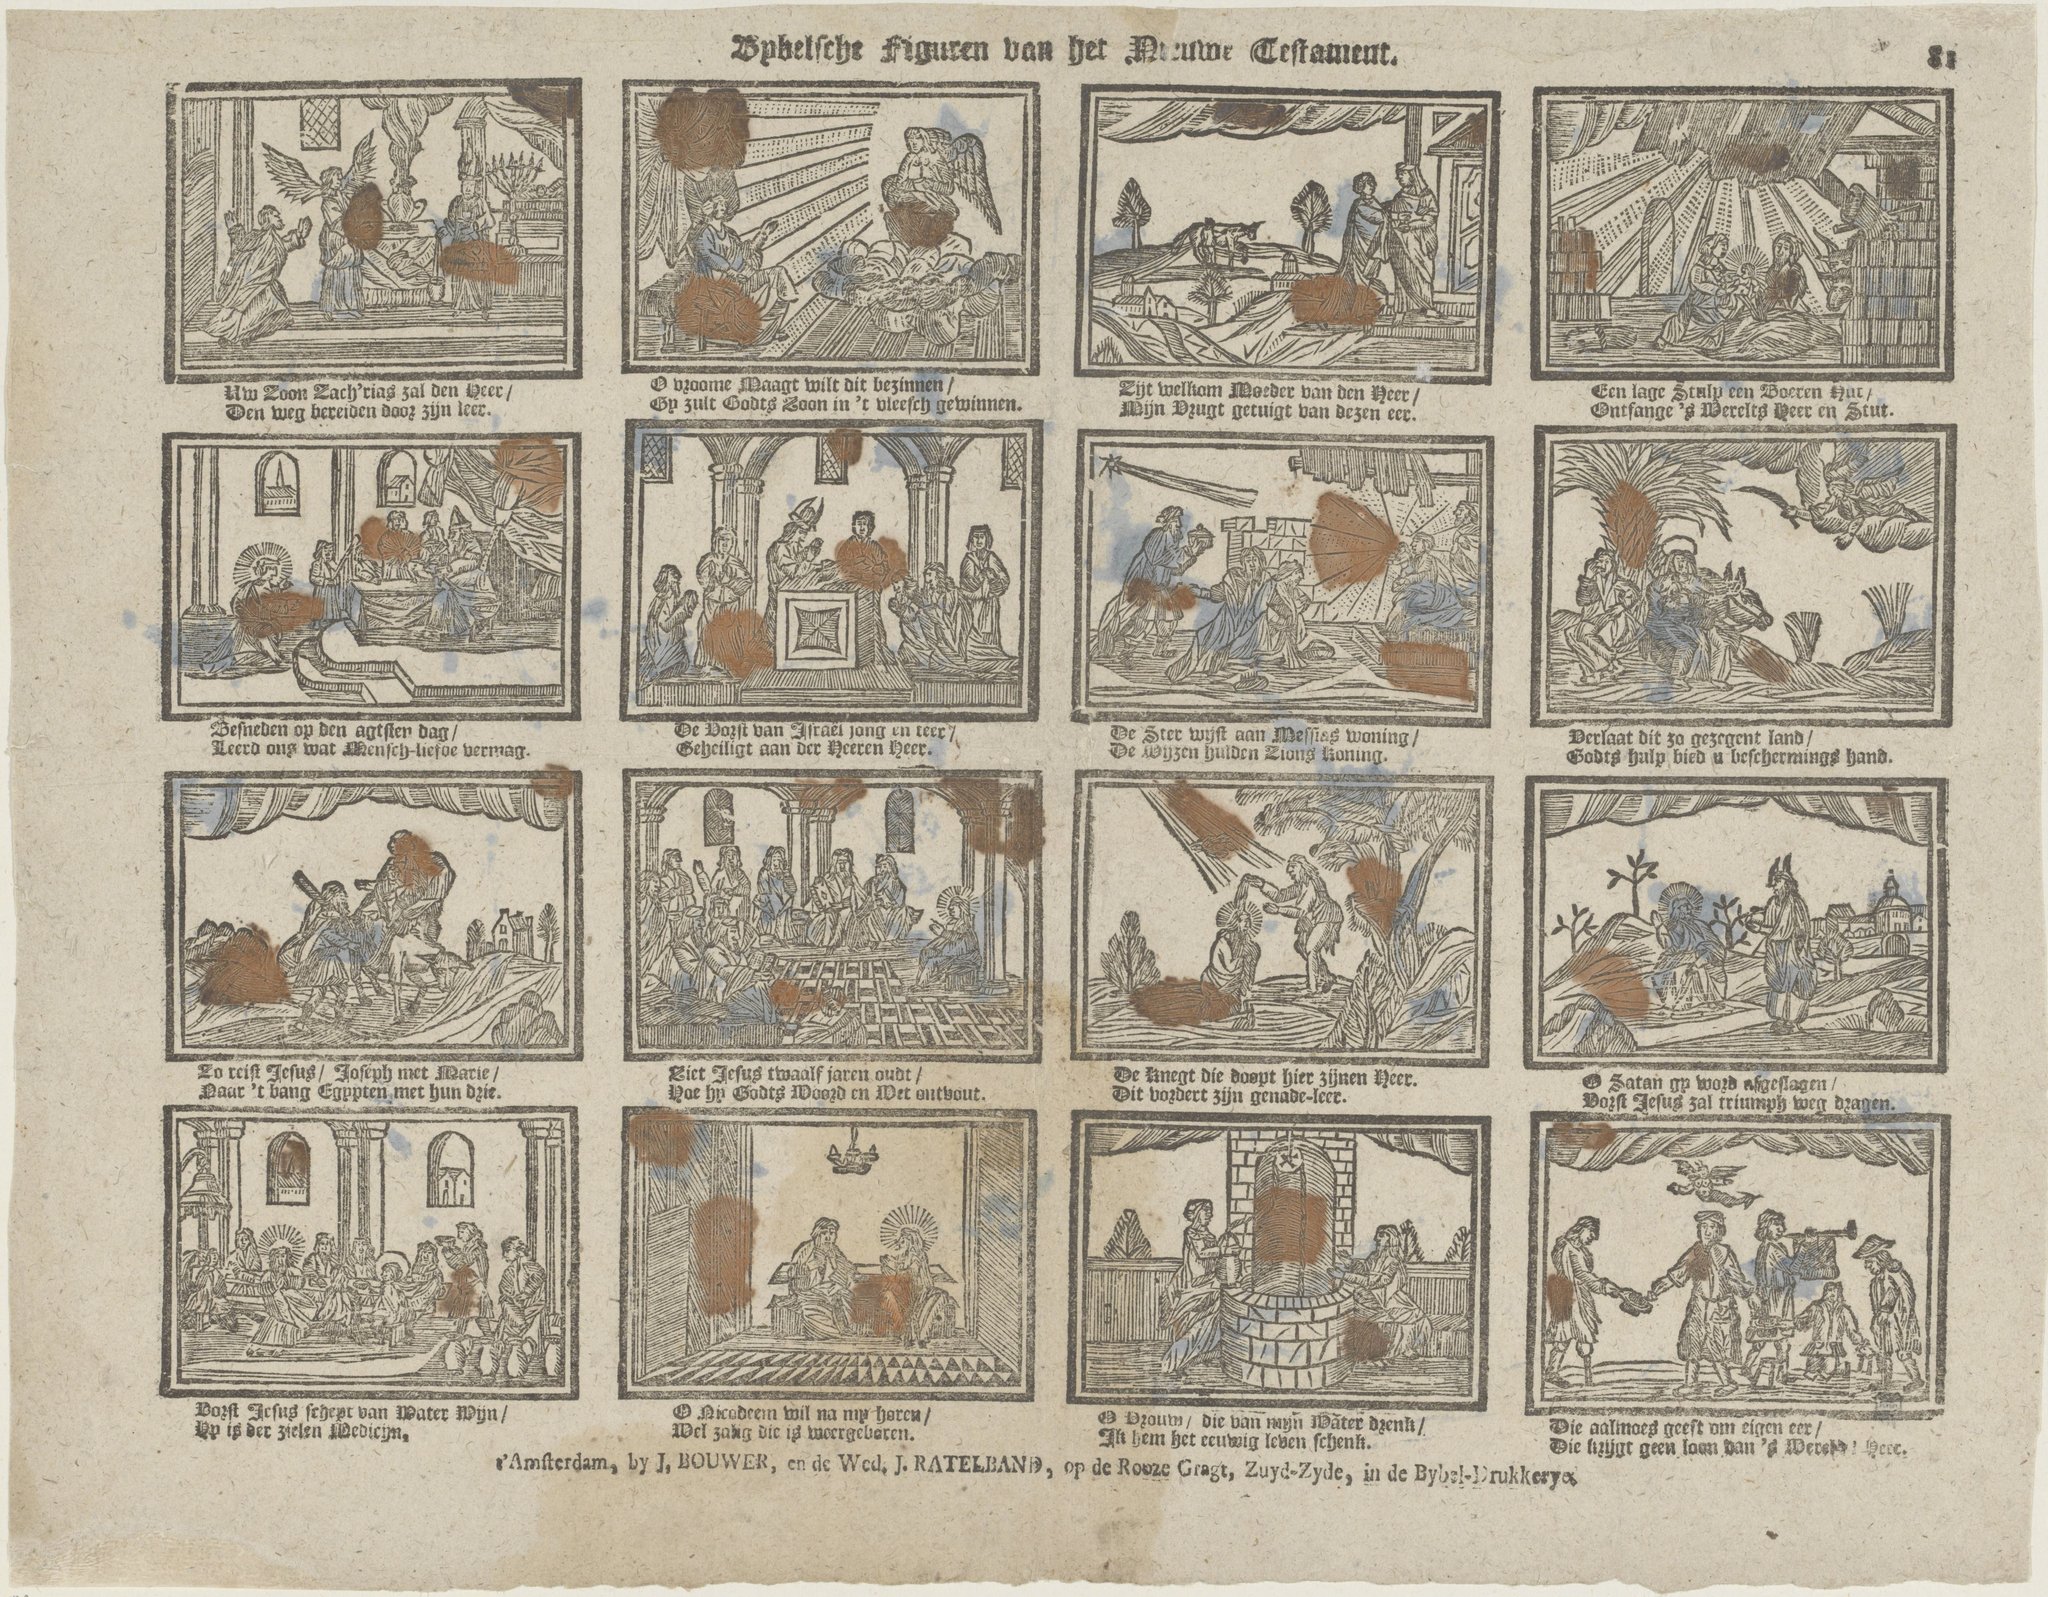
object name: print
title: Bybelsche figuren van het Nieuwe Testament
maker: Anonymous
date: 1794-1804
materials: paper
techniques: colour, letterpress printing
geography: amsterdam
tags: new testament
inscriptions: collector's mark: Lugt 2760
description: Blad met 16 voorstellingen van verhalen uit het Nieuwe Testament. Onder elke afbeelding een tweeregelig vers. Genummerd rechtsboven: 81.